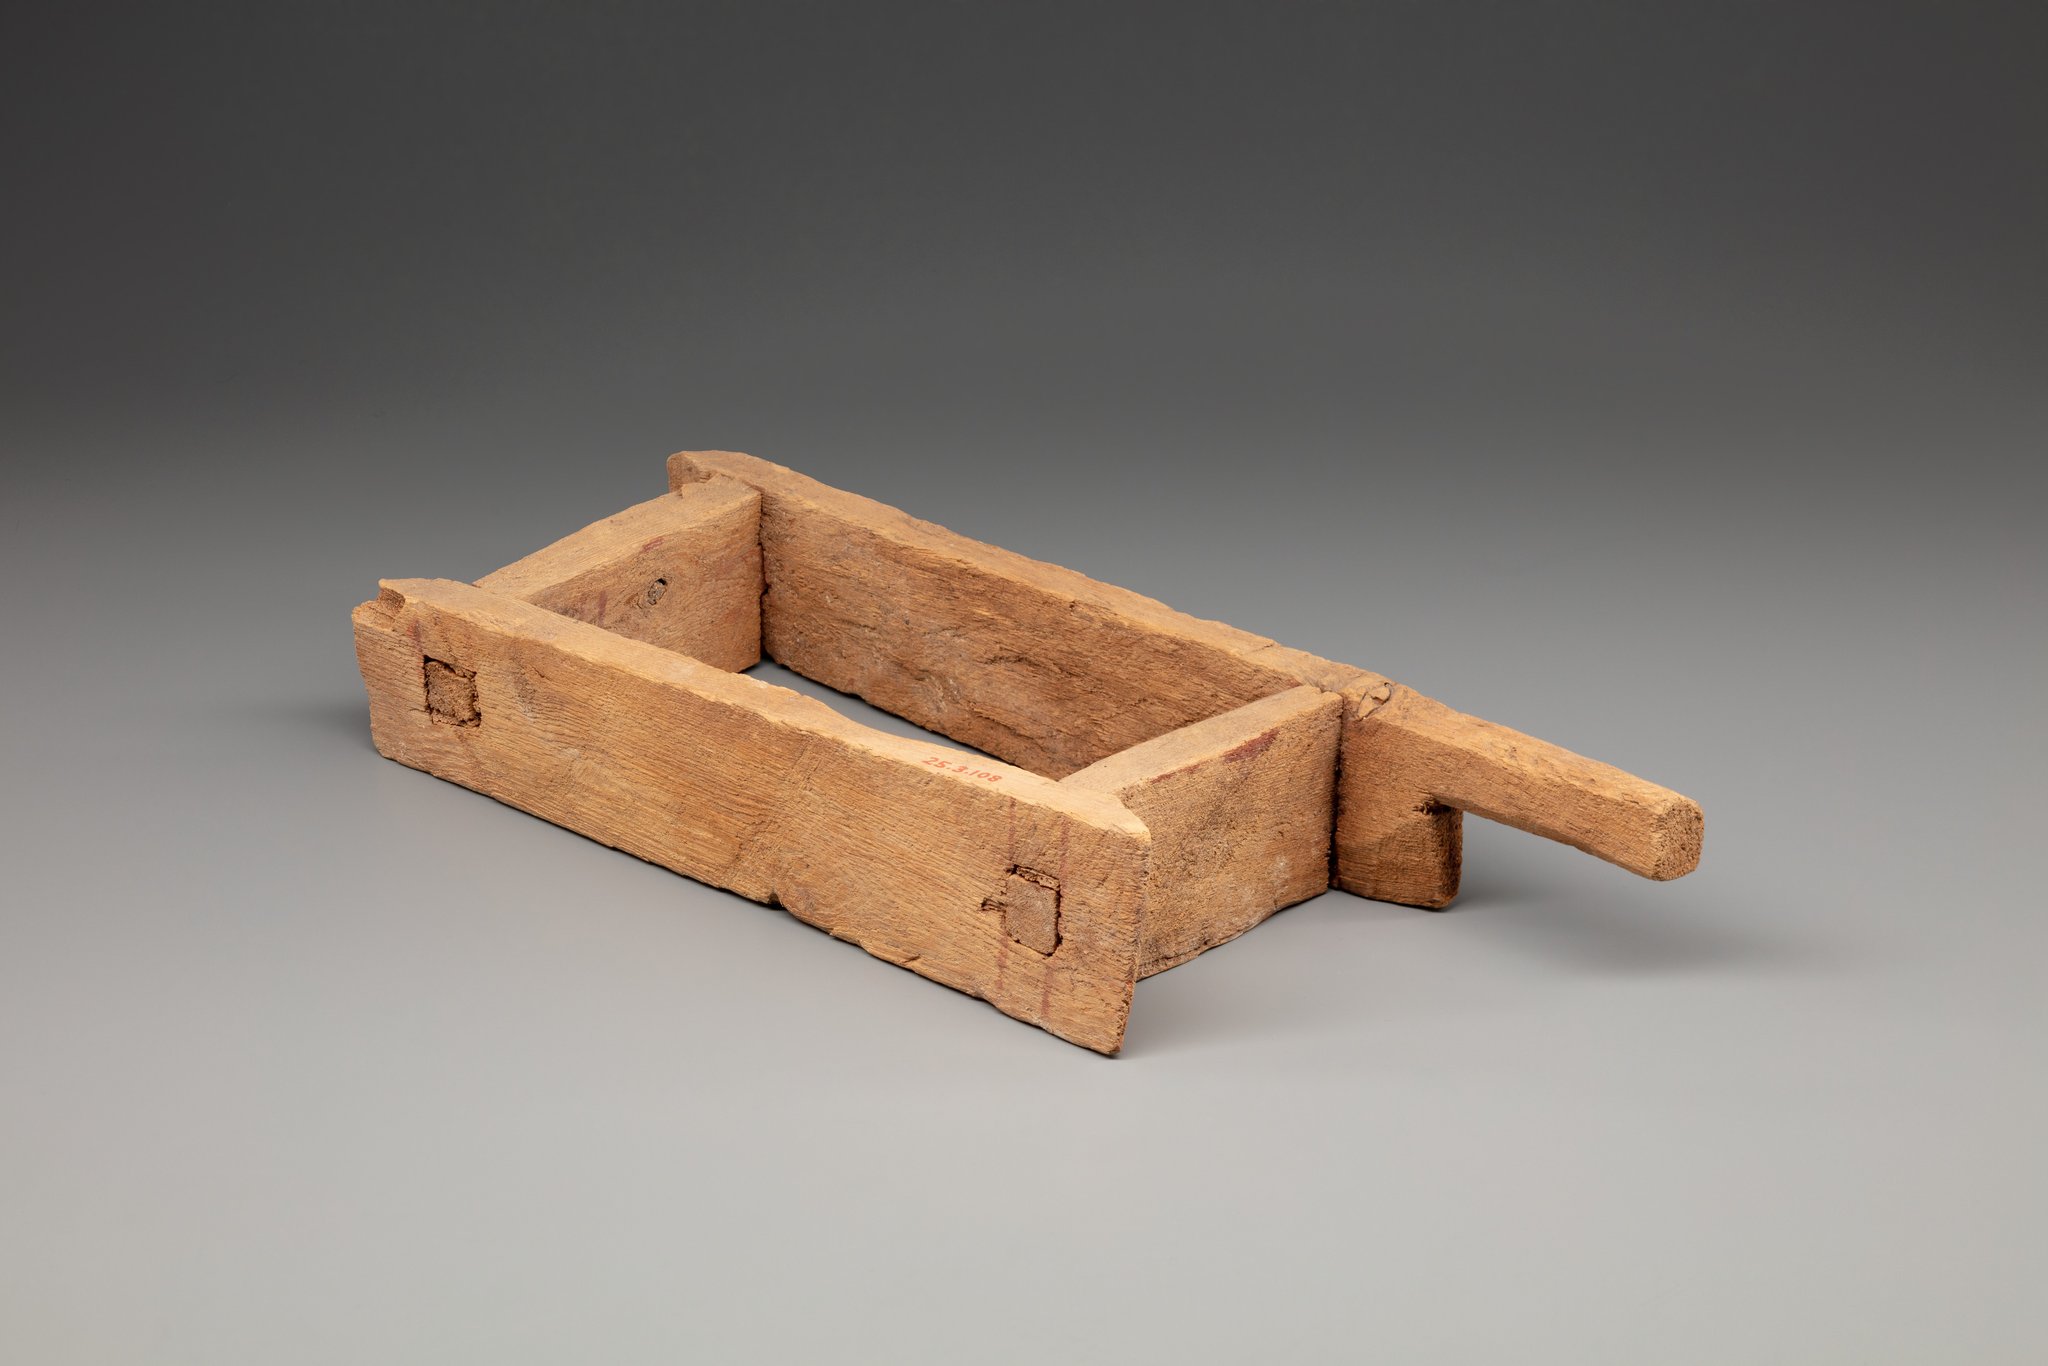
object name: brick mold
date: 1550-1295 BCE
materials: wood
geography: egypt